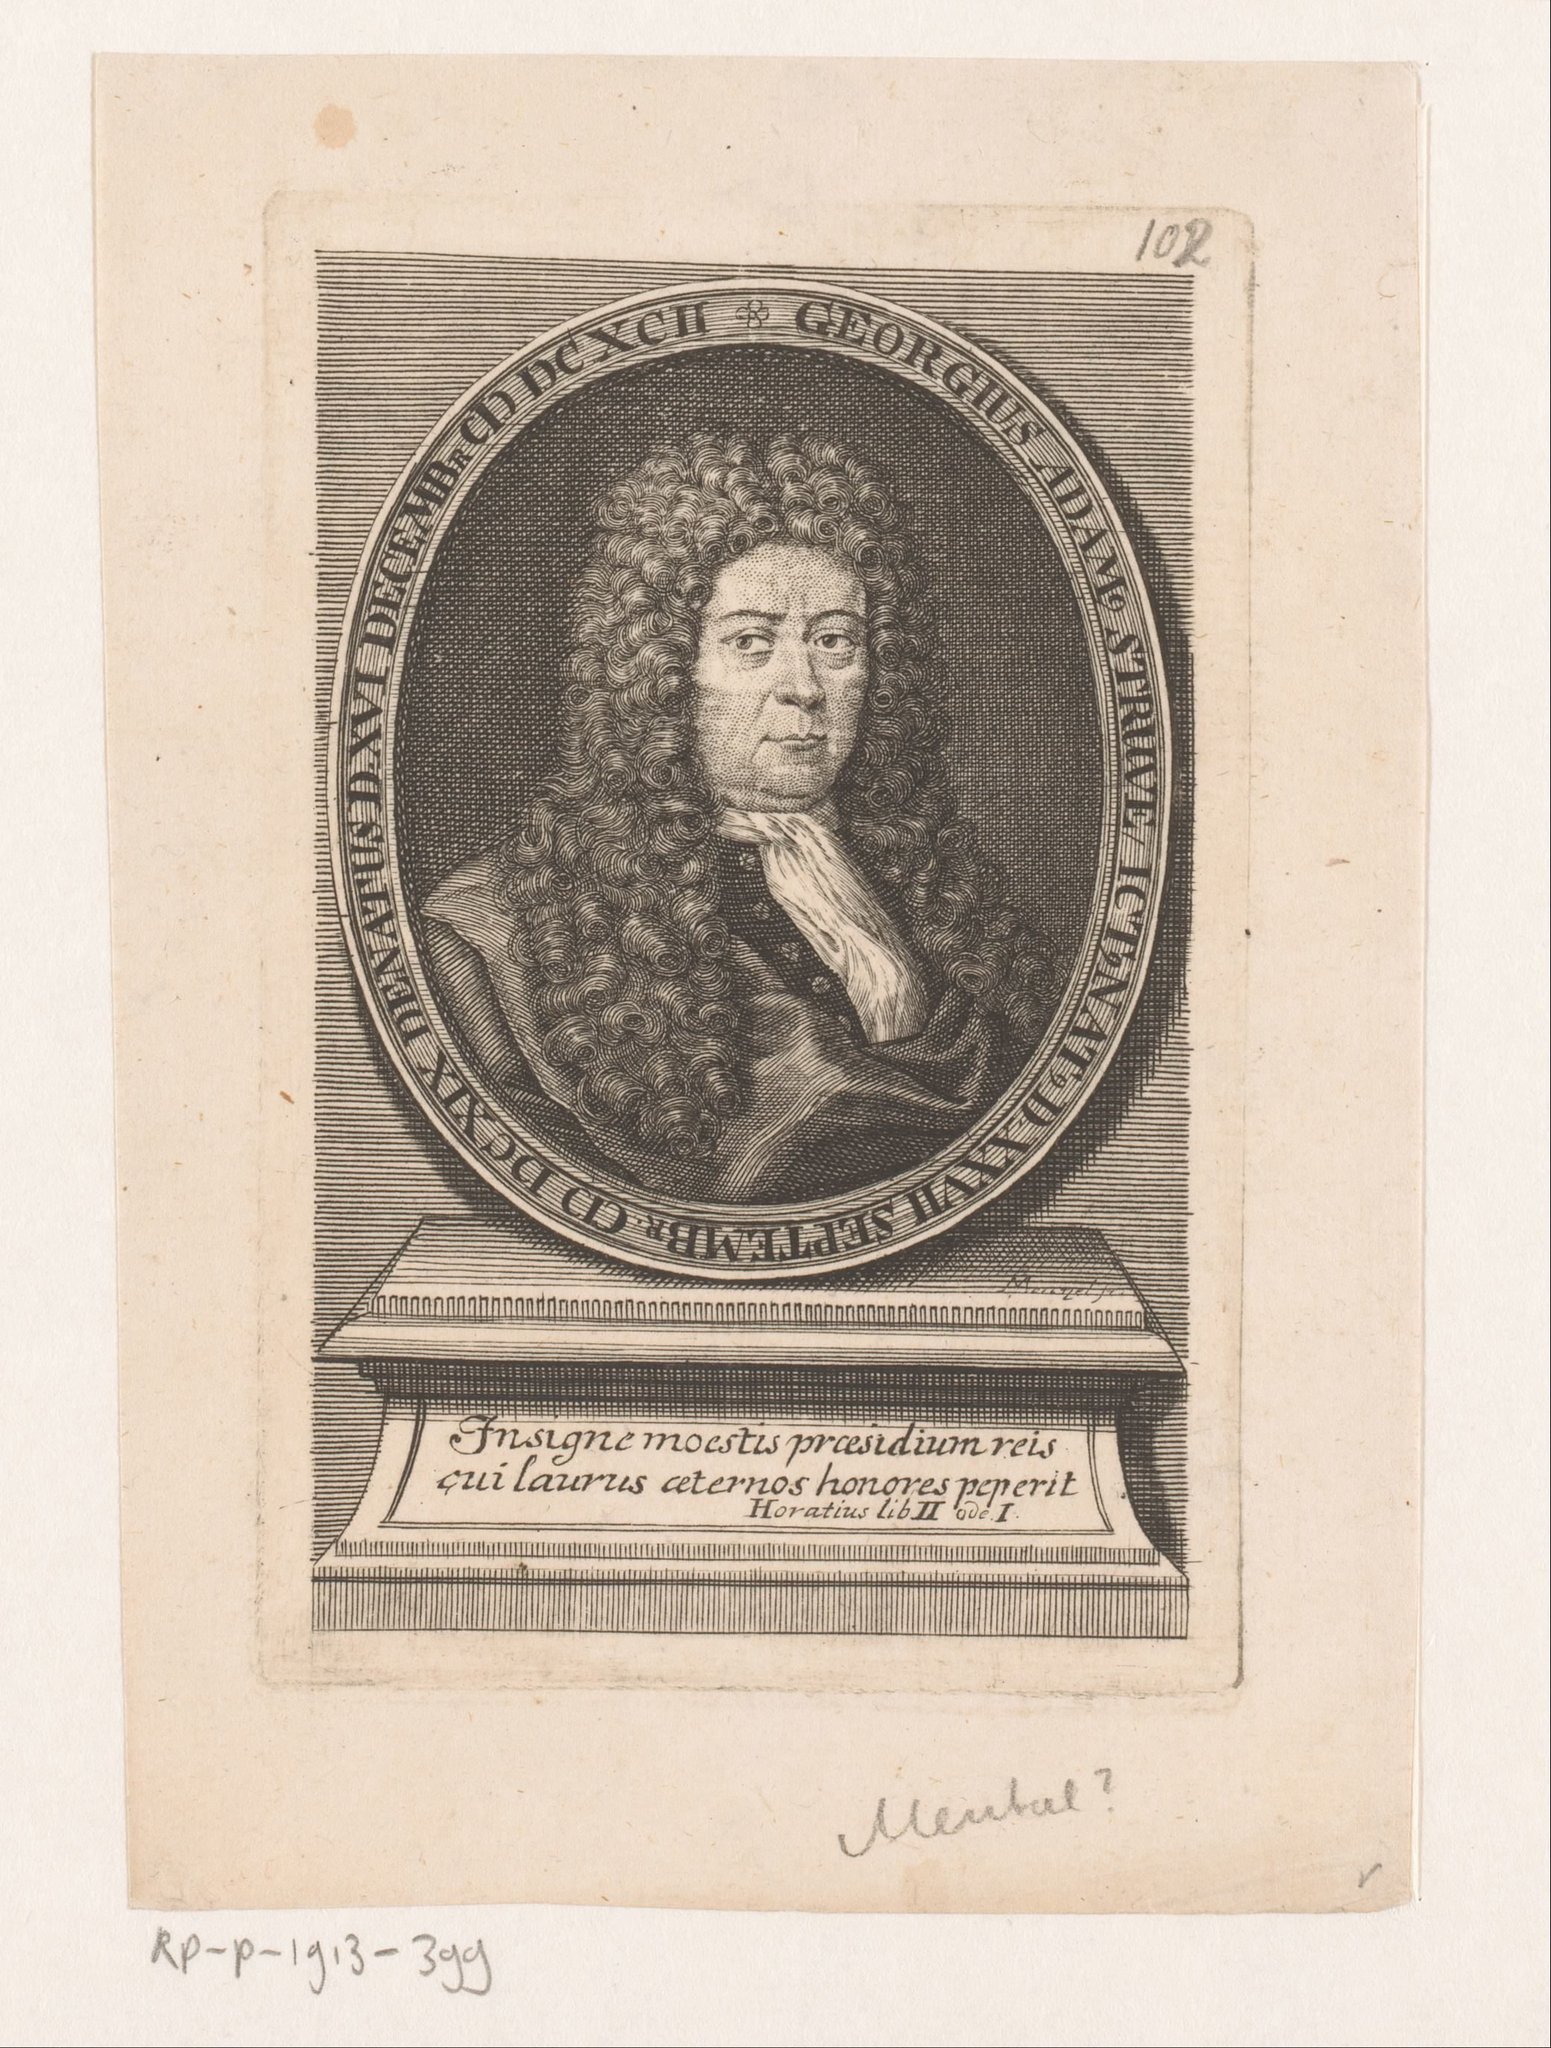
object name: print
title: Portret van Georg Adam Struve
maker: johann georg mentzel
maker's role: print maker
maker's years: 1677-1743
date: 1687-1743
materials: paper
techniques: engraving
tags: historical persons, wig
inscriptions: collector's mark: Lugt 2228